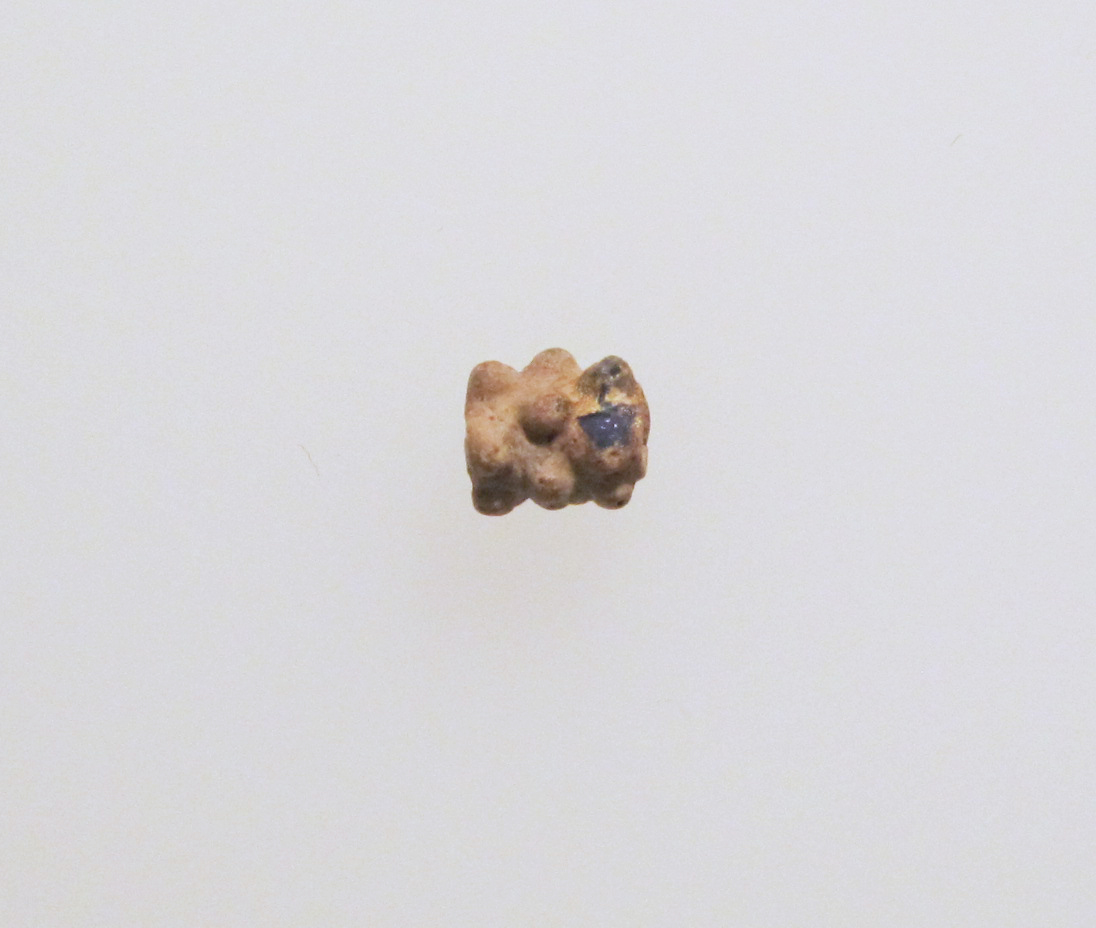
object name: bead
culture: roman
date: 670 BCE-330 CE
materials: glass